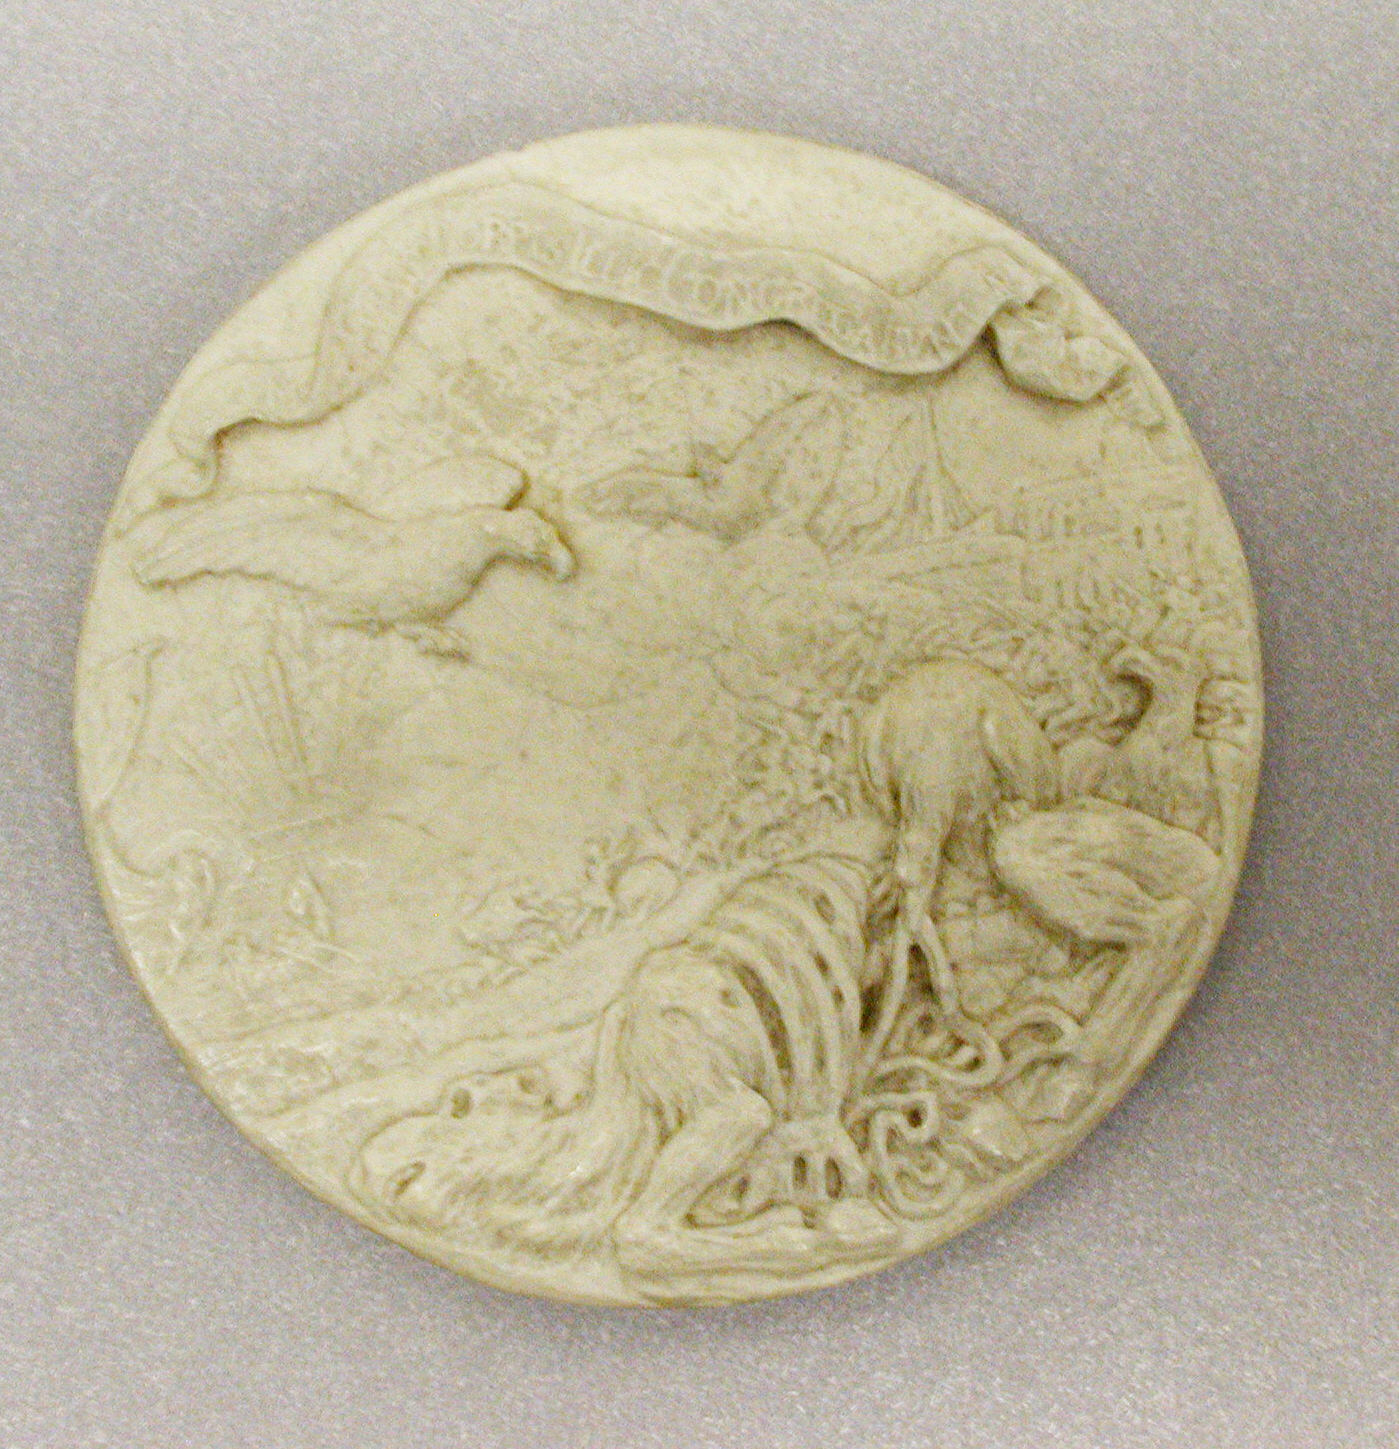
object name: medallion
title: Copy of The Relief of Vienna, September 12, 1683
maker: johan ignaz bendl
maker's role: artist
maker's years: 1630-1730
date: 1801-1900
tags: animals,birds